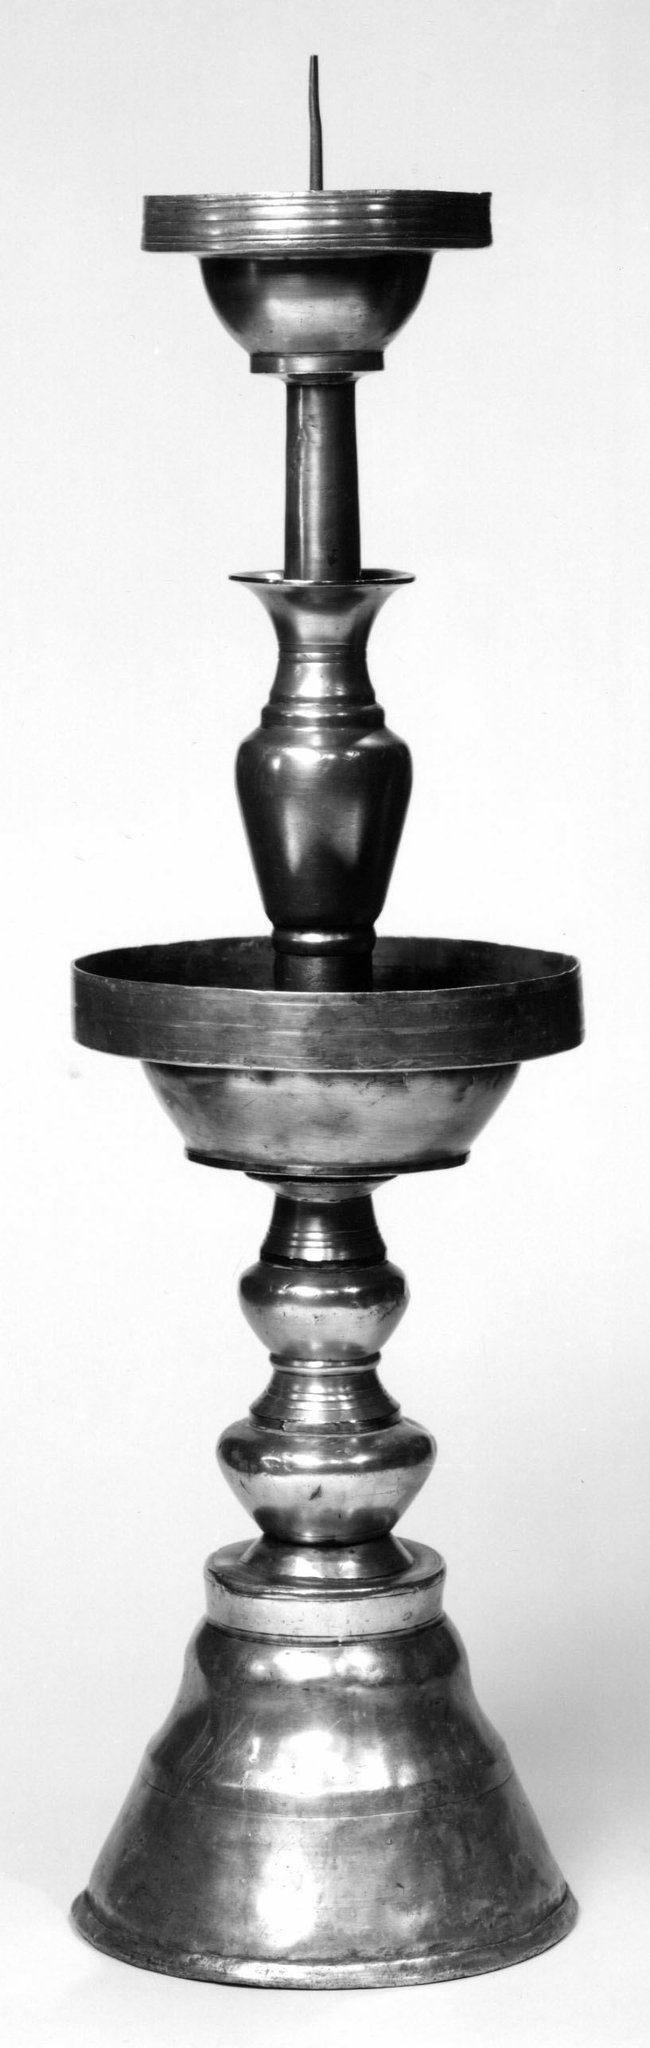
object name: candlestick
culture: chinese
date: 1601-1700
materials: pewter